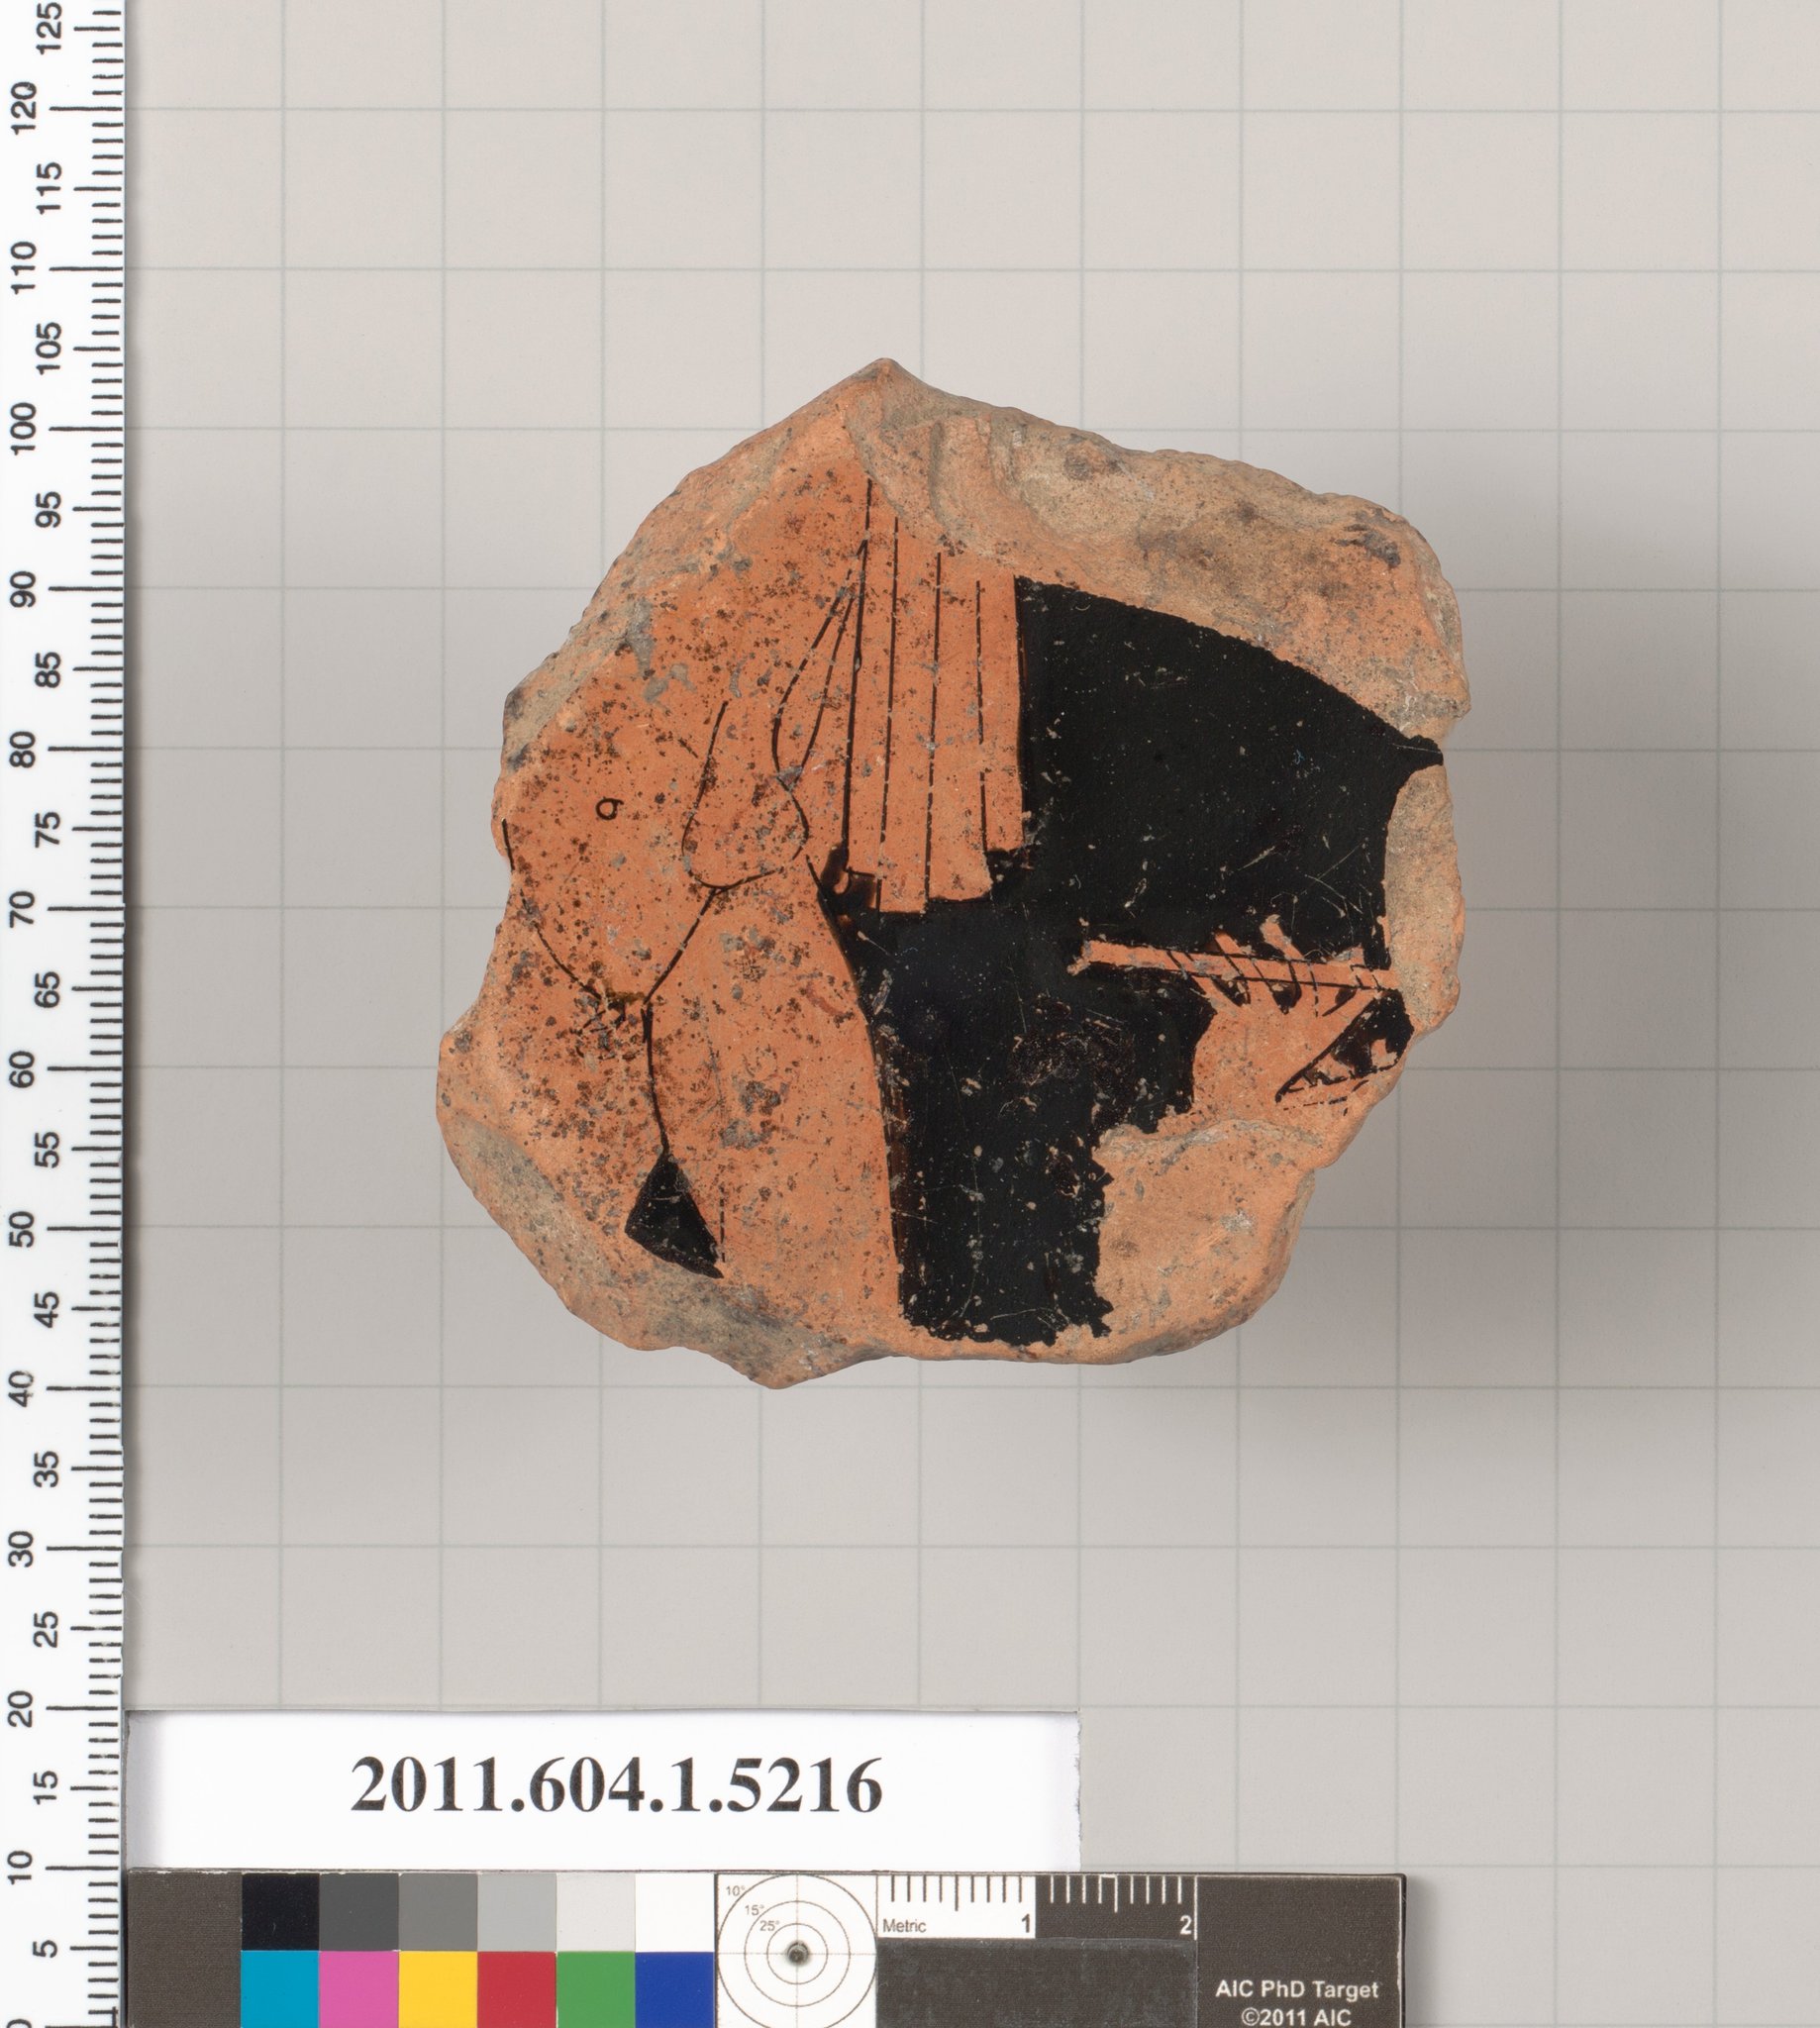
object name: kylix fragment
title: Terracotta fragment of a kylix (drinking cup)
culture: greek, attic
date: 500-480 BCE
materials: terracotta